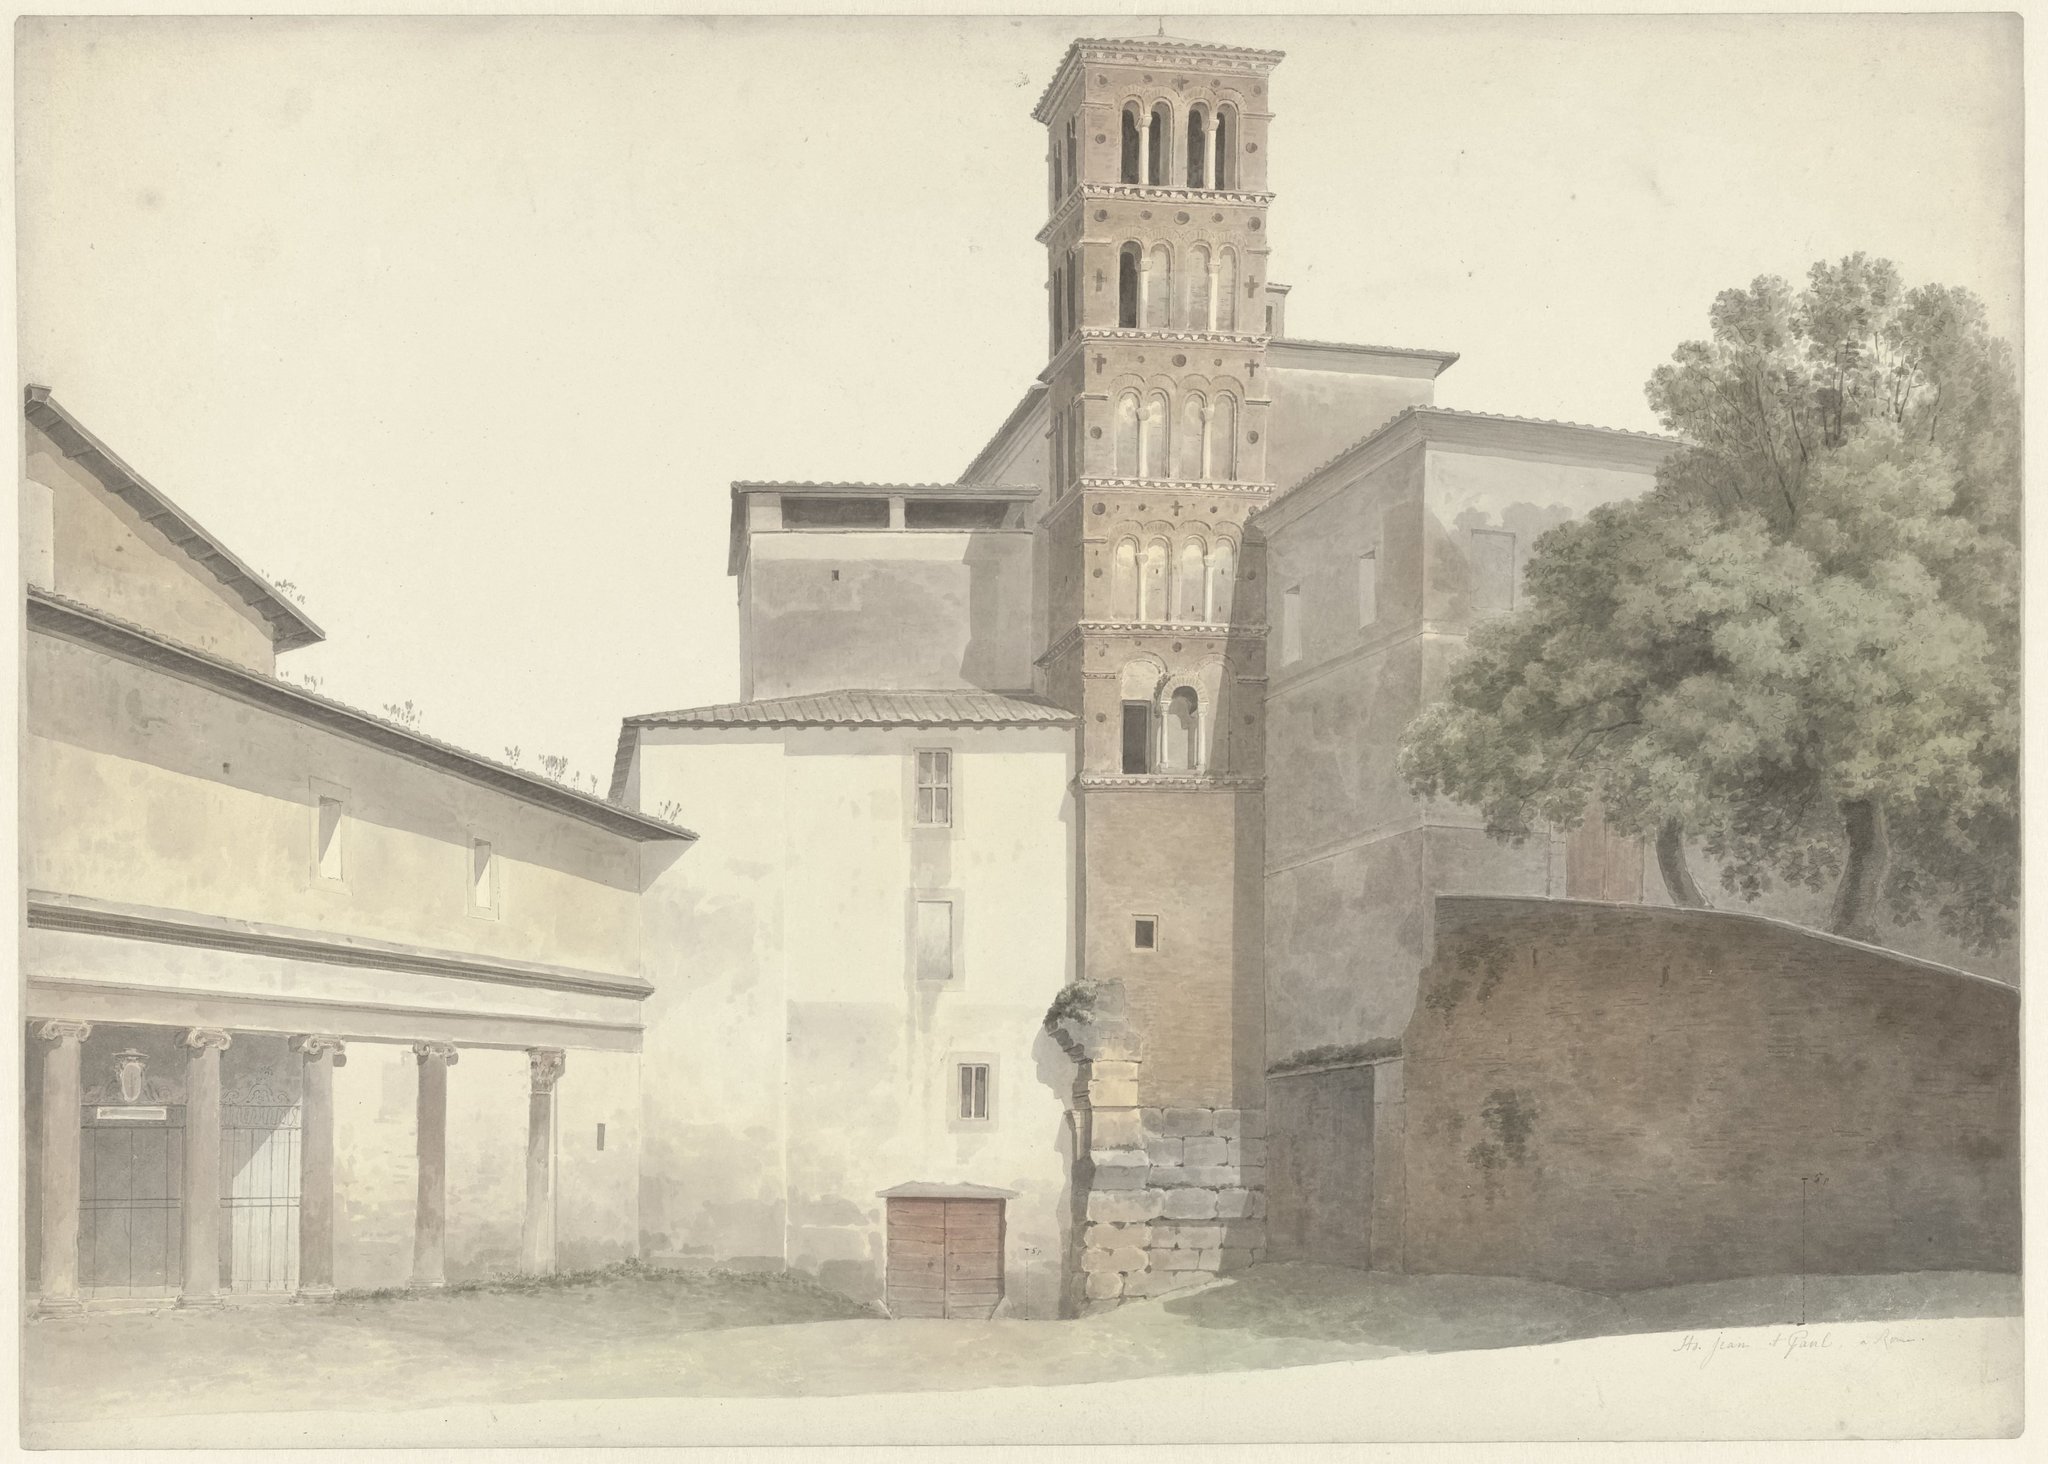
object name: drawing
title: Basilica and Monastery of SS. Giovanni e Paolo in Rome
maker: josephus augustus knip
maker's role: draughtsman, painter, print maker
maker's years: 1777-1847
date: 1809-1812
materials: graphite, paper, watercolor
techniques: brush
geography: italy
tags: rome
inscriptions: inscription: ‘Sts. Jean et Paul, a Rome’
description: At the left can be seen the porch and part of the façade of the church. It is said to have been built on the site where the house of the patron saints, John and Paul, once stood. The two brothers died as martyrs in the 4th century AD. At centre we see the Romanesque bell tower dating from the mid- 12th century, surrounded by the monastery complex.